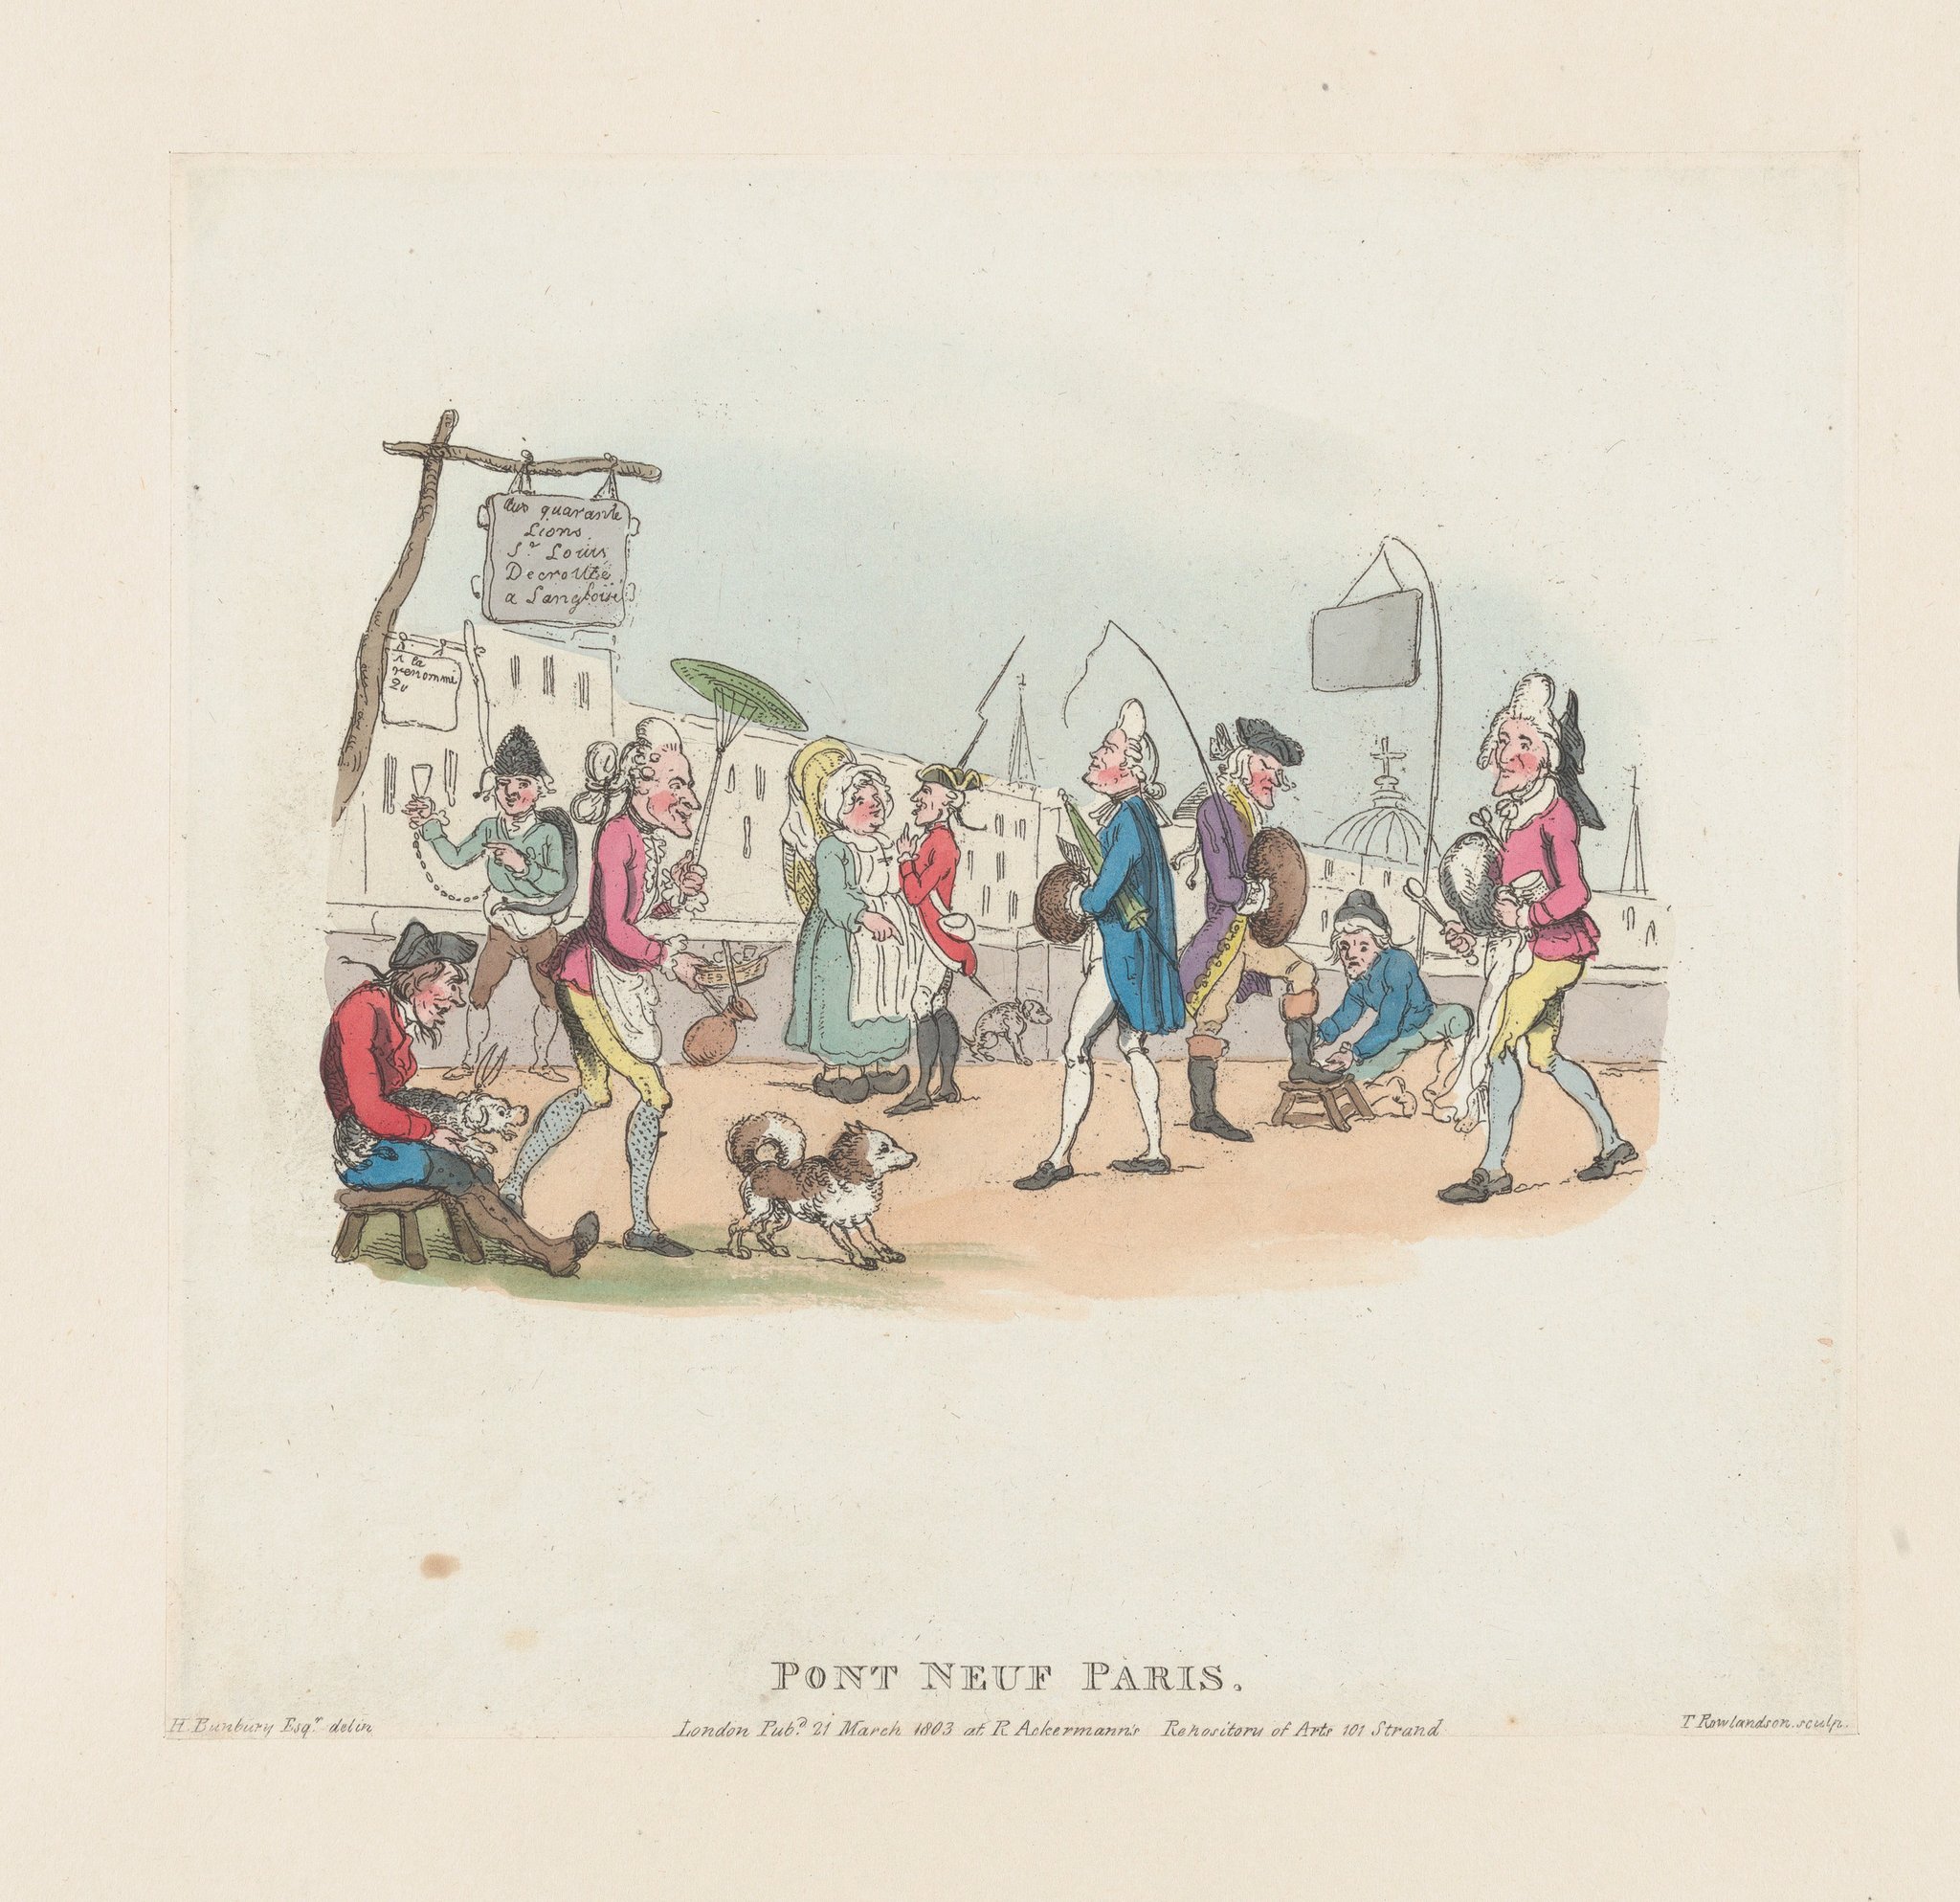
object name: print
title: Pont Neuf, Paris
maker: thomas rowlandson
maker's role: artist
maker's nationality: british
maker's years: 1757-1827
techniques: etching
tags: satire,men,women,dogs